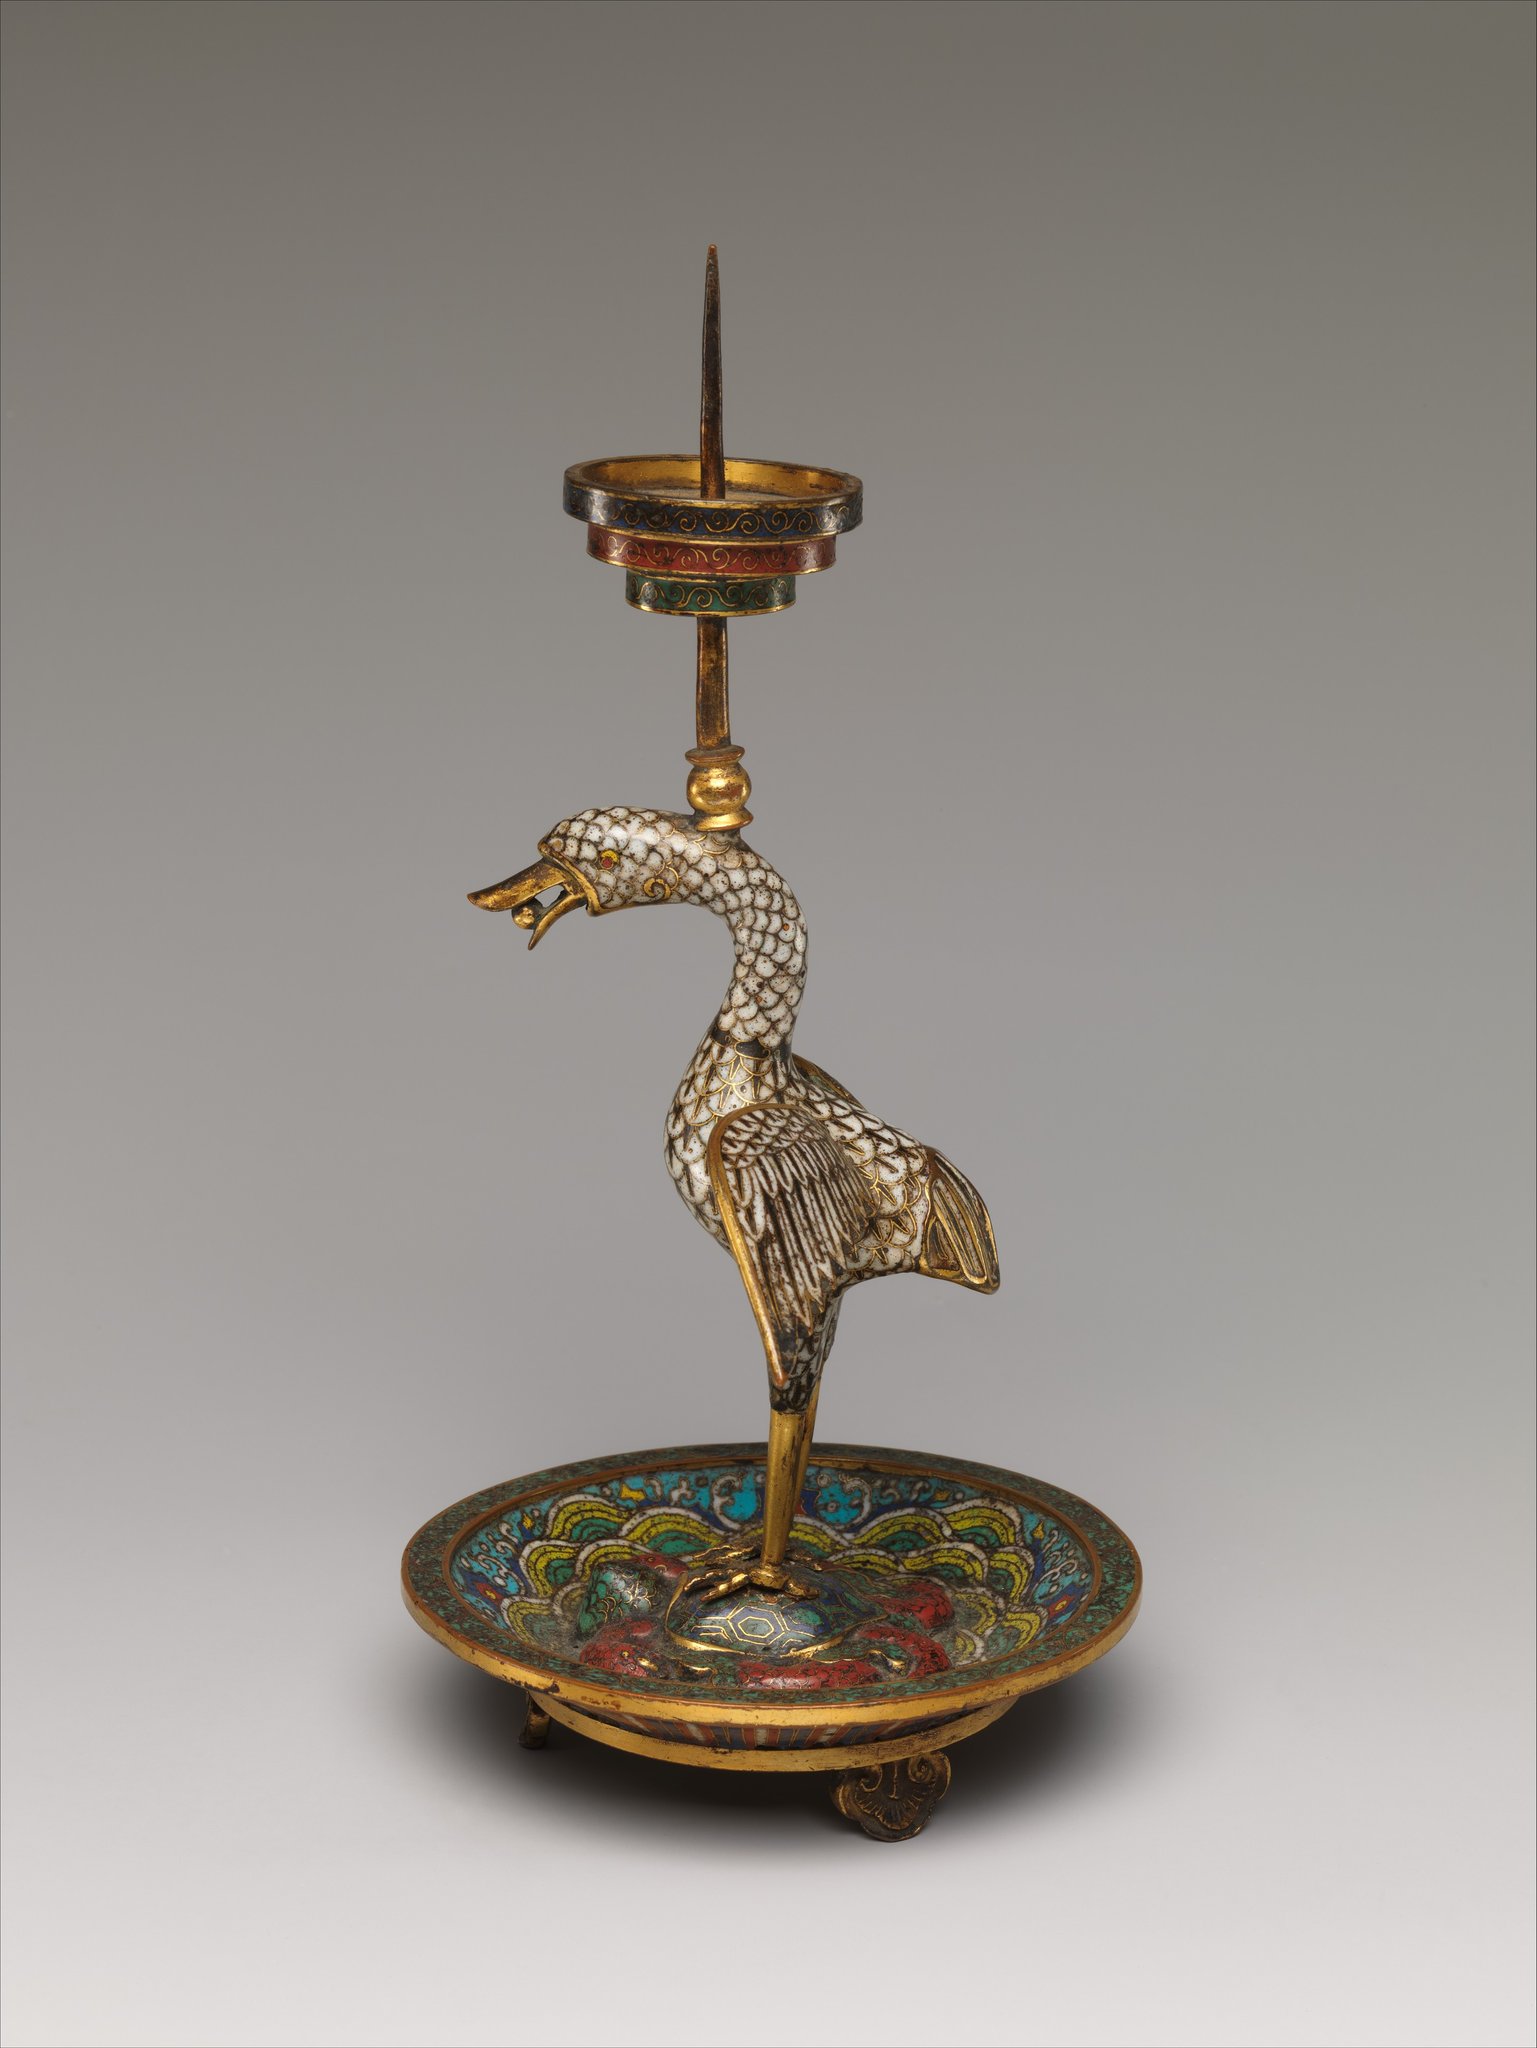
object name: candlestick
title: Candlestick (one of a pair)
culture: chinese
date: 1736-1795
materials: enamel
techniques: enamel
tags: birds